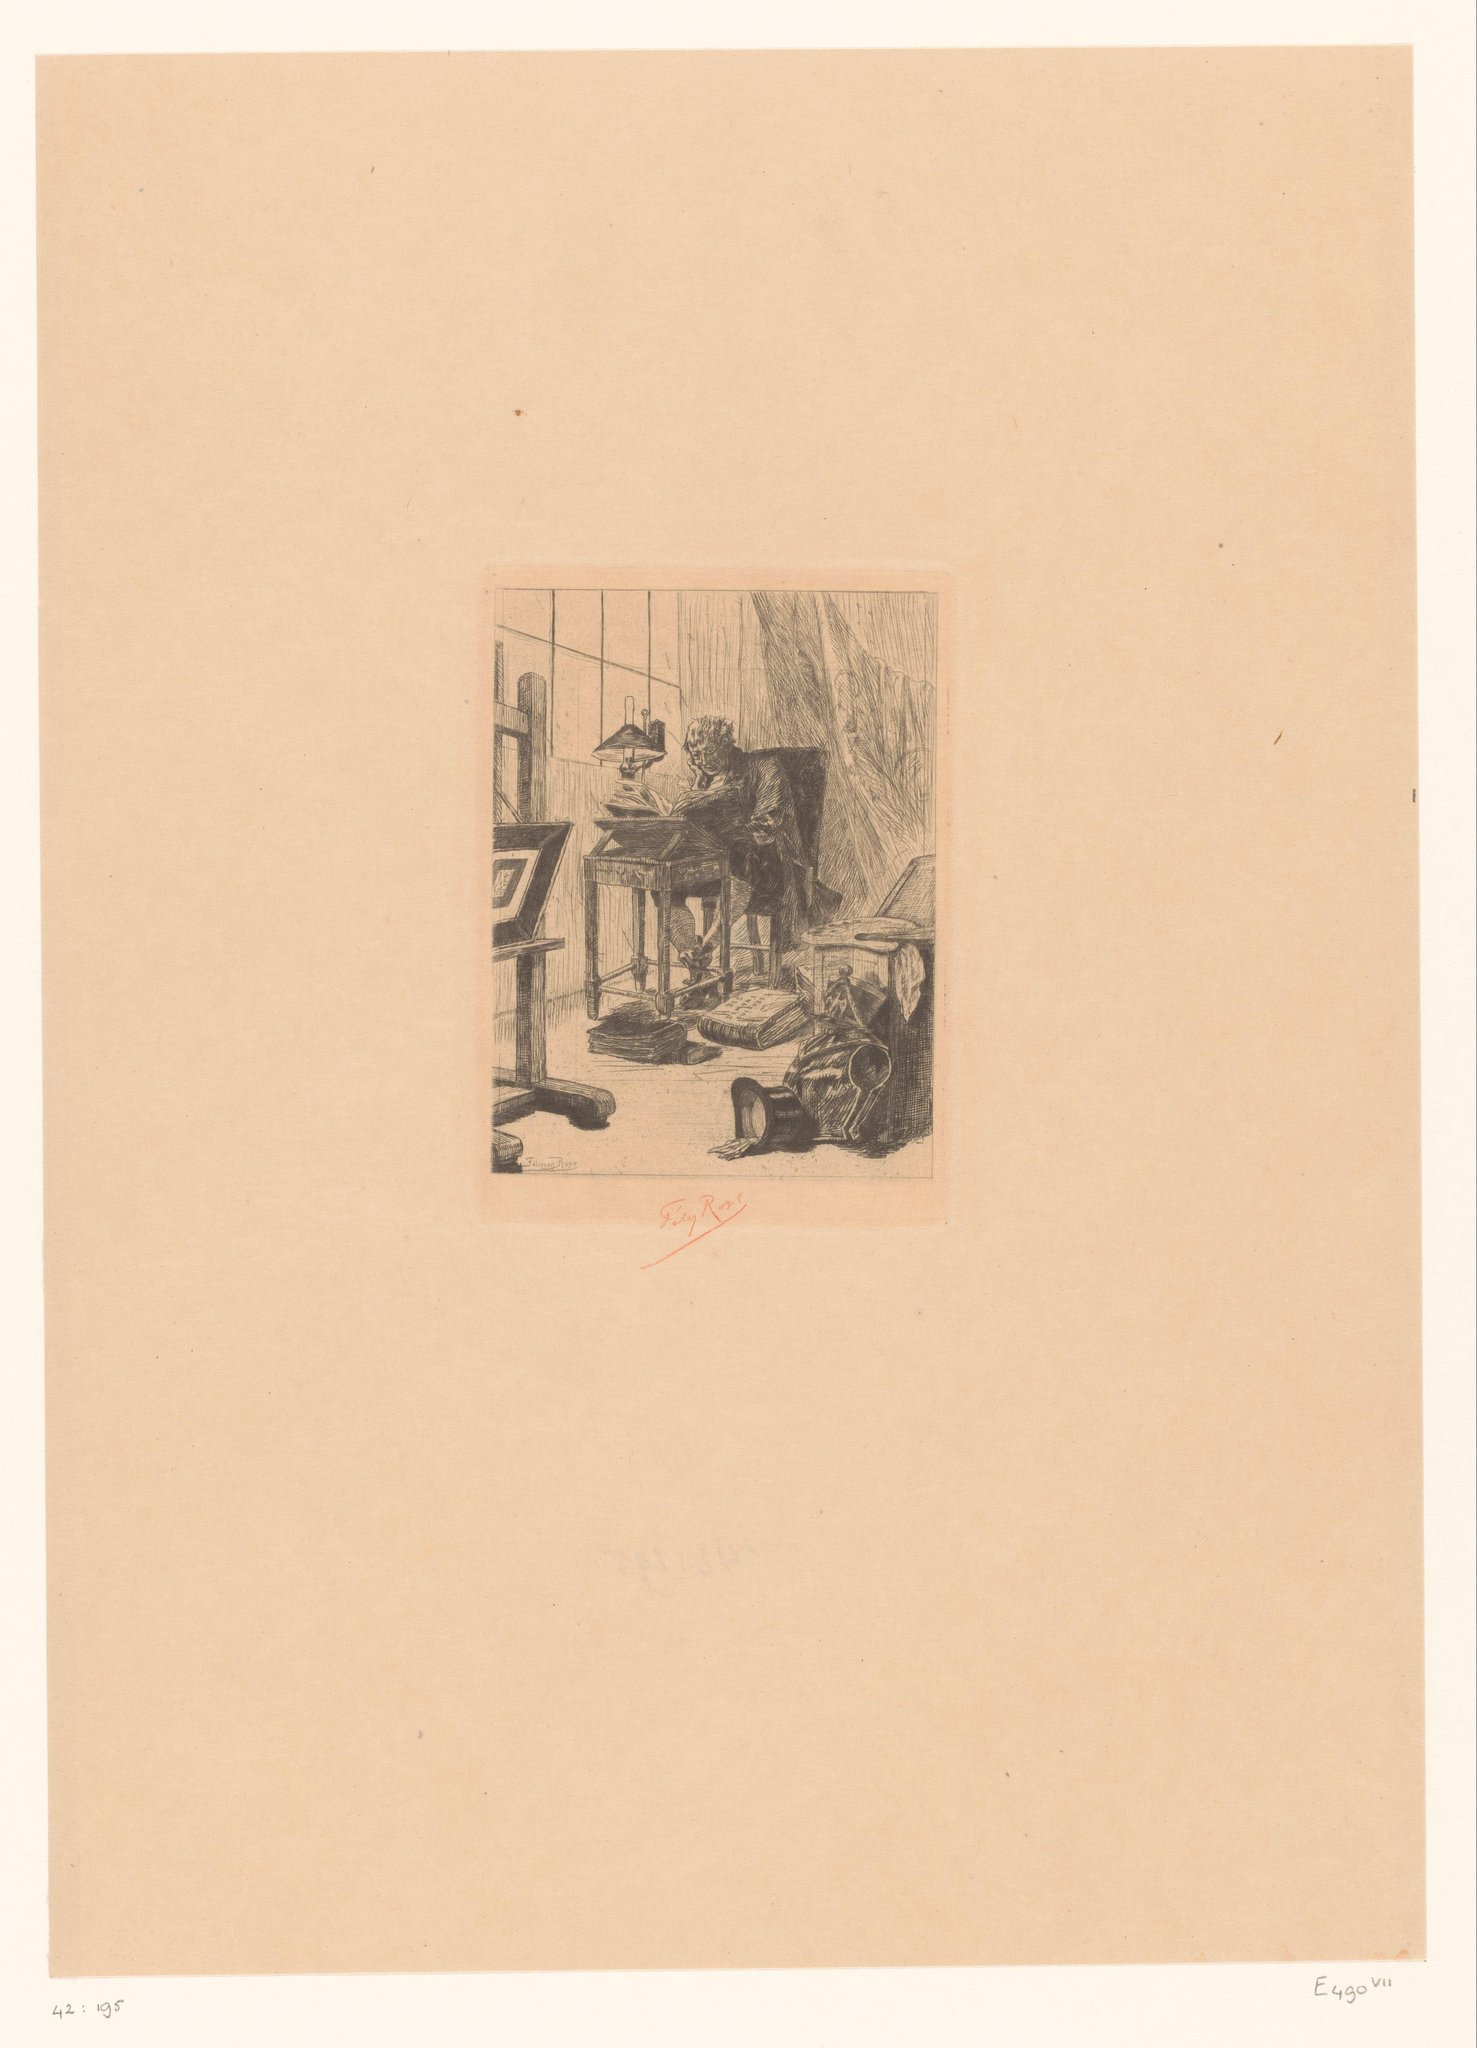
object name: book illustration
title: Oude man leest in een studeerkamer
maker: félicien rops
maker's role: draughtsman, print maker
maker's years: 1833-1898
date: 1881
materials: paper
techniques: drypoint, etching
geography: brussels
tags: scholar in his study, reading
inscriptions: collector's mark: Lugt 2228, collector's mark: Lugt 2760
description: Prent gebruikt in: Hannon, Théodore. Rimes de joie. Brussel: Gay en Doucé, 1881.